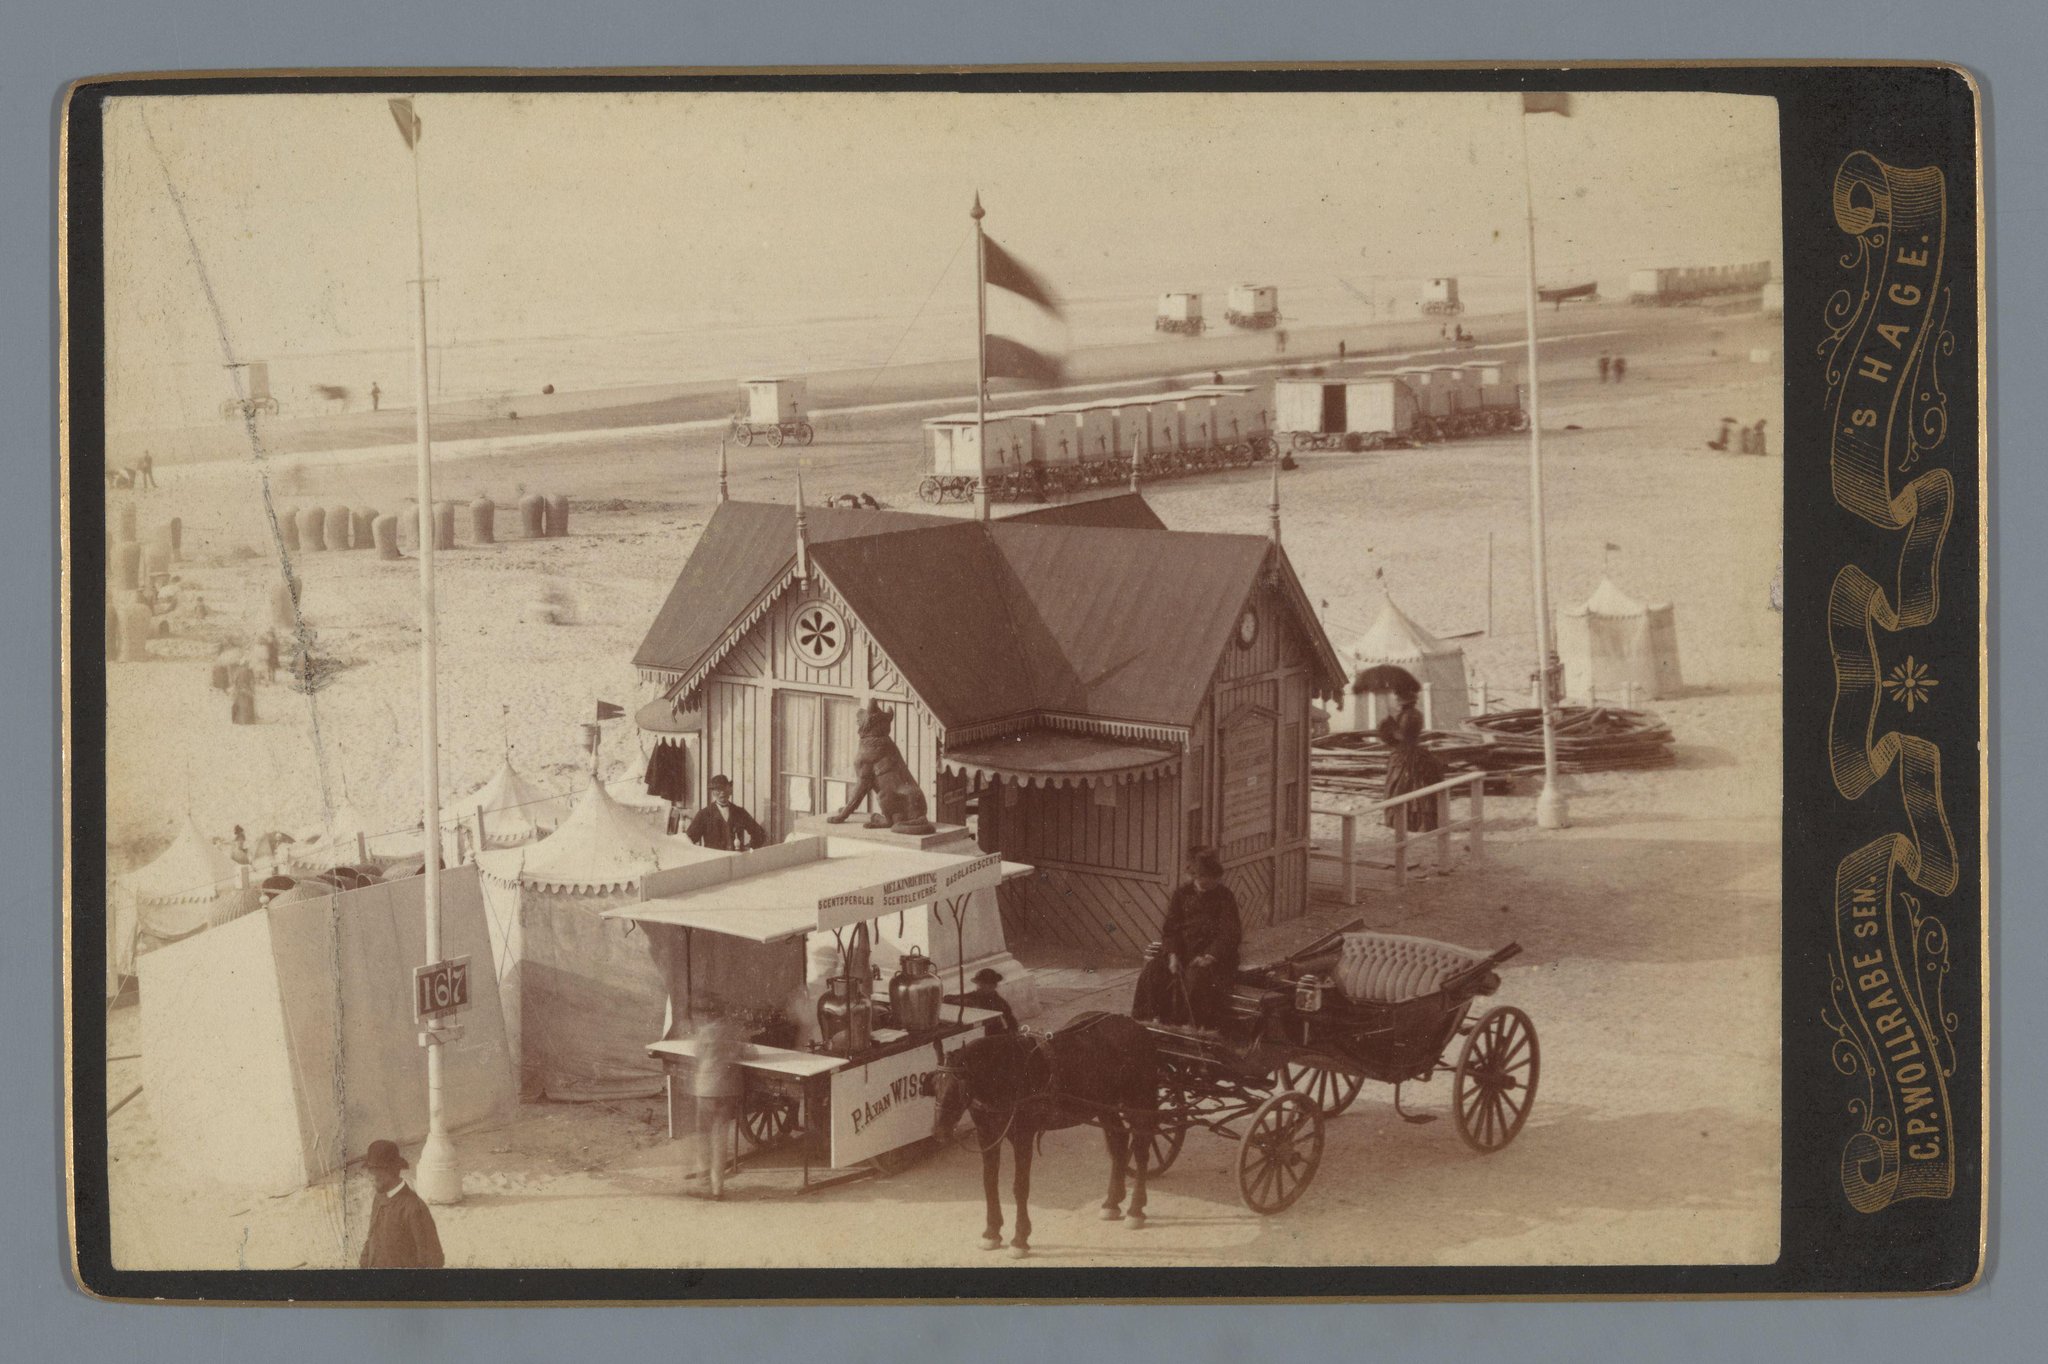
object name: photograph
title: Houten paviljoen op het strand te Scheveningen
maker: carl philip wollrabe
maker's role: fotograaf, musicus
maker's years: 1812-1887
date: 1885-1900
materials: cardboard, photographic support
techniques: albumen print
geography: scheveningen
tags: beach (as place of recreation), four-wheeled, animal-drawn vehicle, e.g.: cab, carriage, coach, façade (of house or building)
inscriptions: inscription: ‘C.P. Wollrabe sen. (...) De plaat blijft tot nabestelling bewaard.’